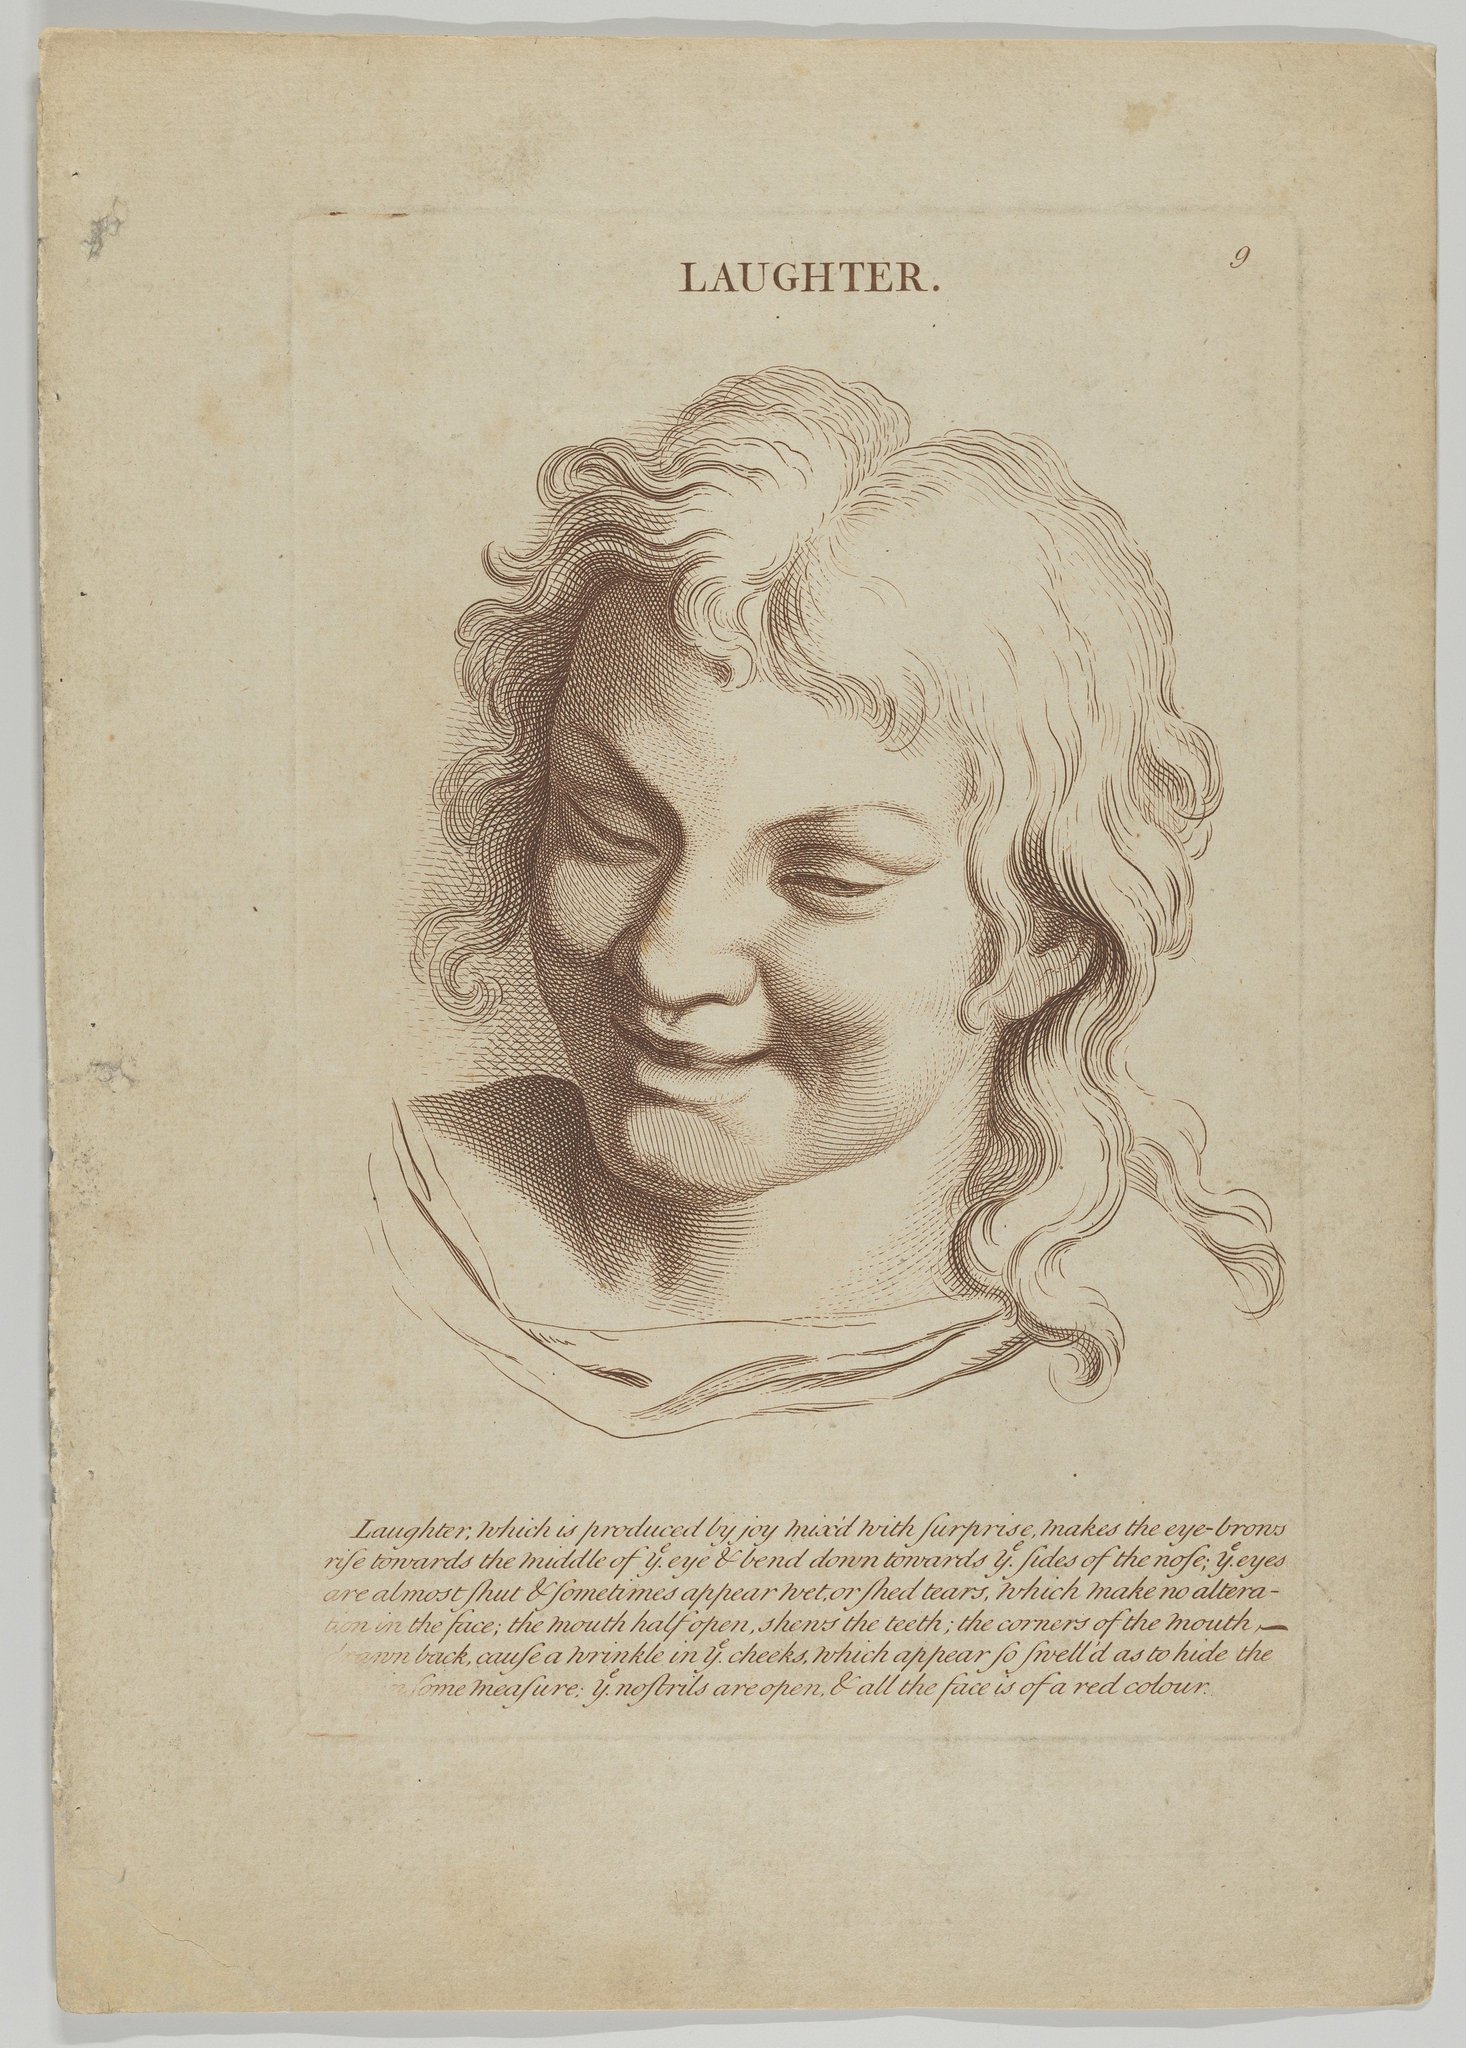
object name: print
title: Laughter, plate 10 from "Heads Representing the Various Passions of the Soul; as they are Expressed in the Human Countenance: Drawn by that Great Master Monsieur Le Brun"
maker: anonymous, british, 18th century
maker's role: engraver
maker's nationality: british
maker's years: 1700-1800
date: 1765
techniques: engraving, etching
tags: heads